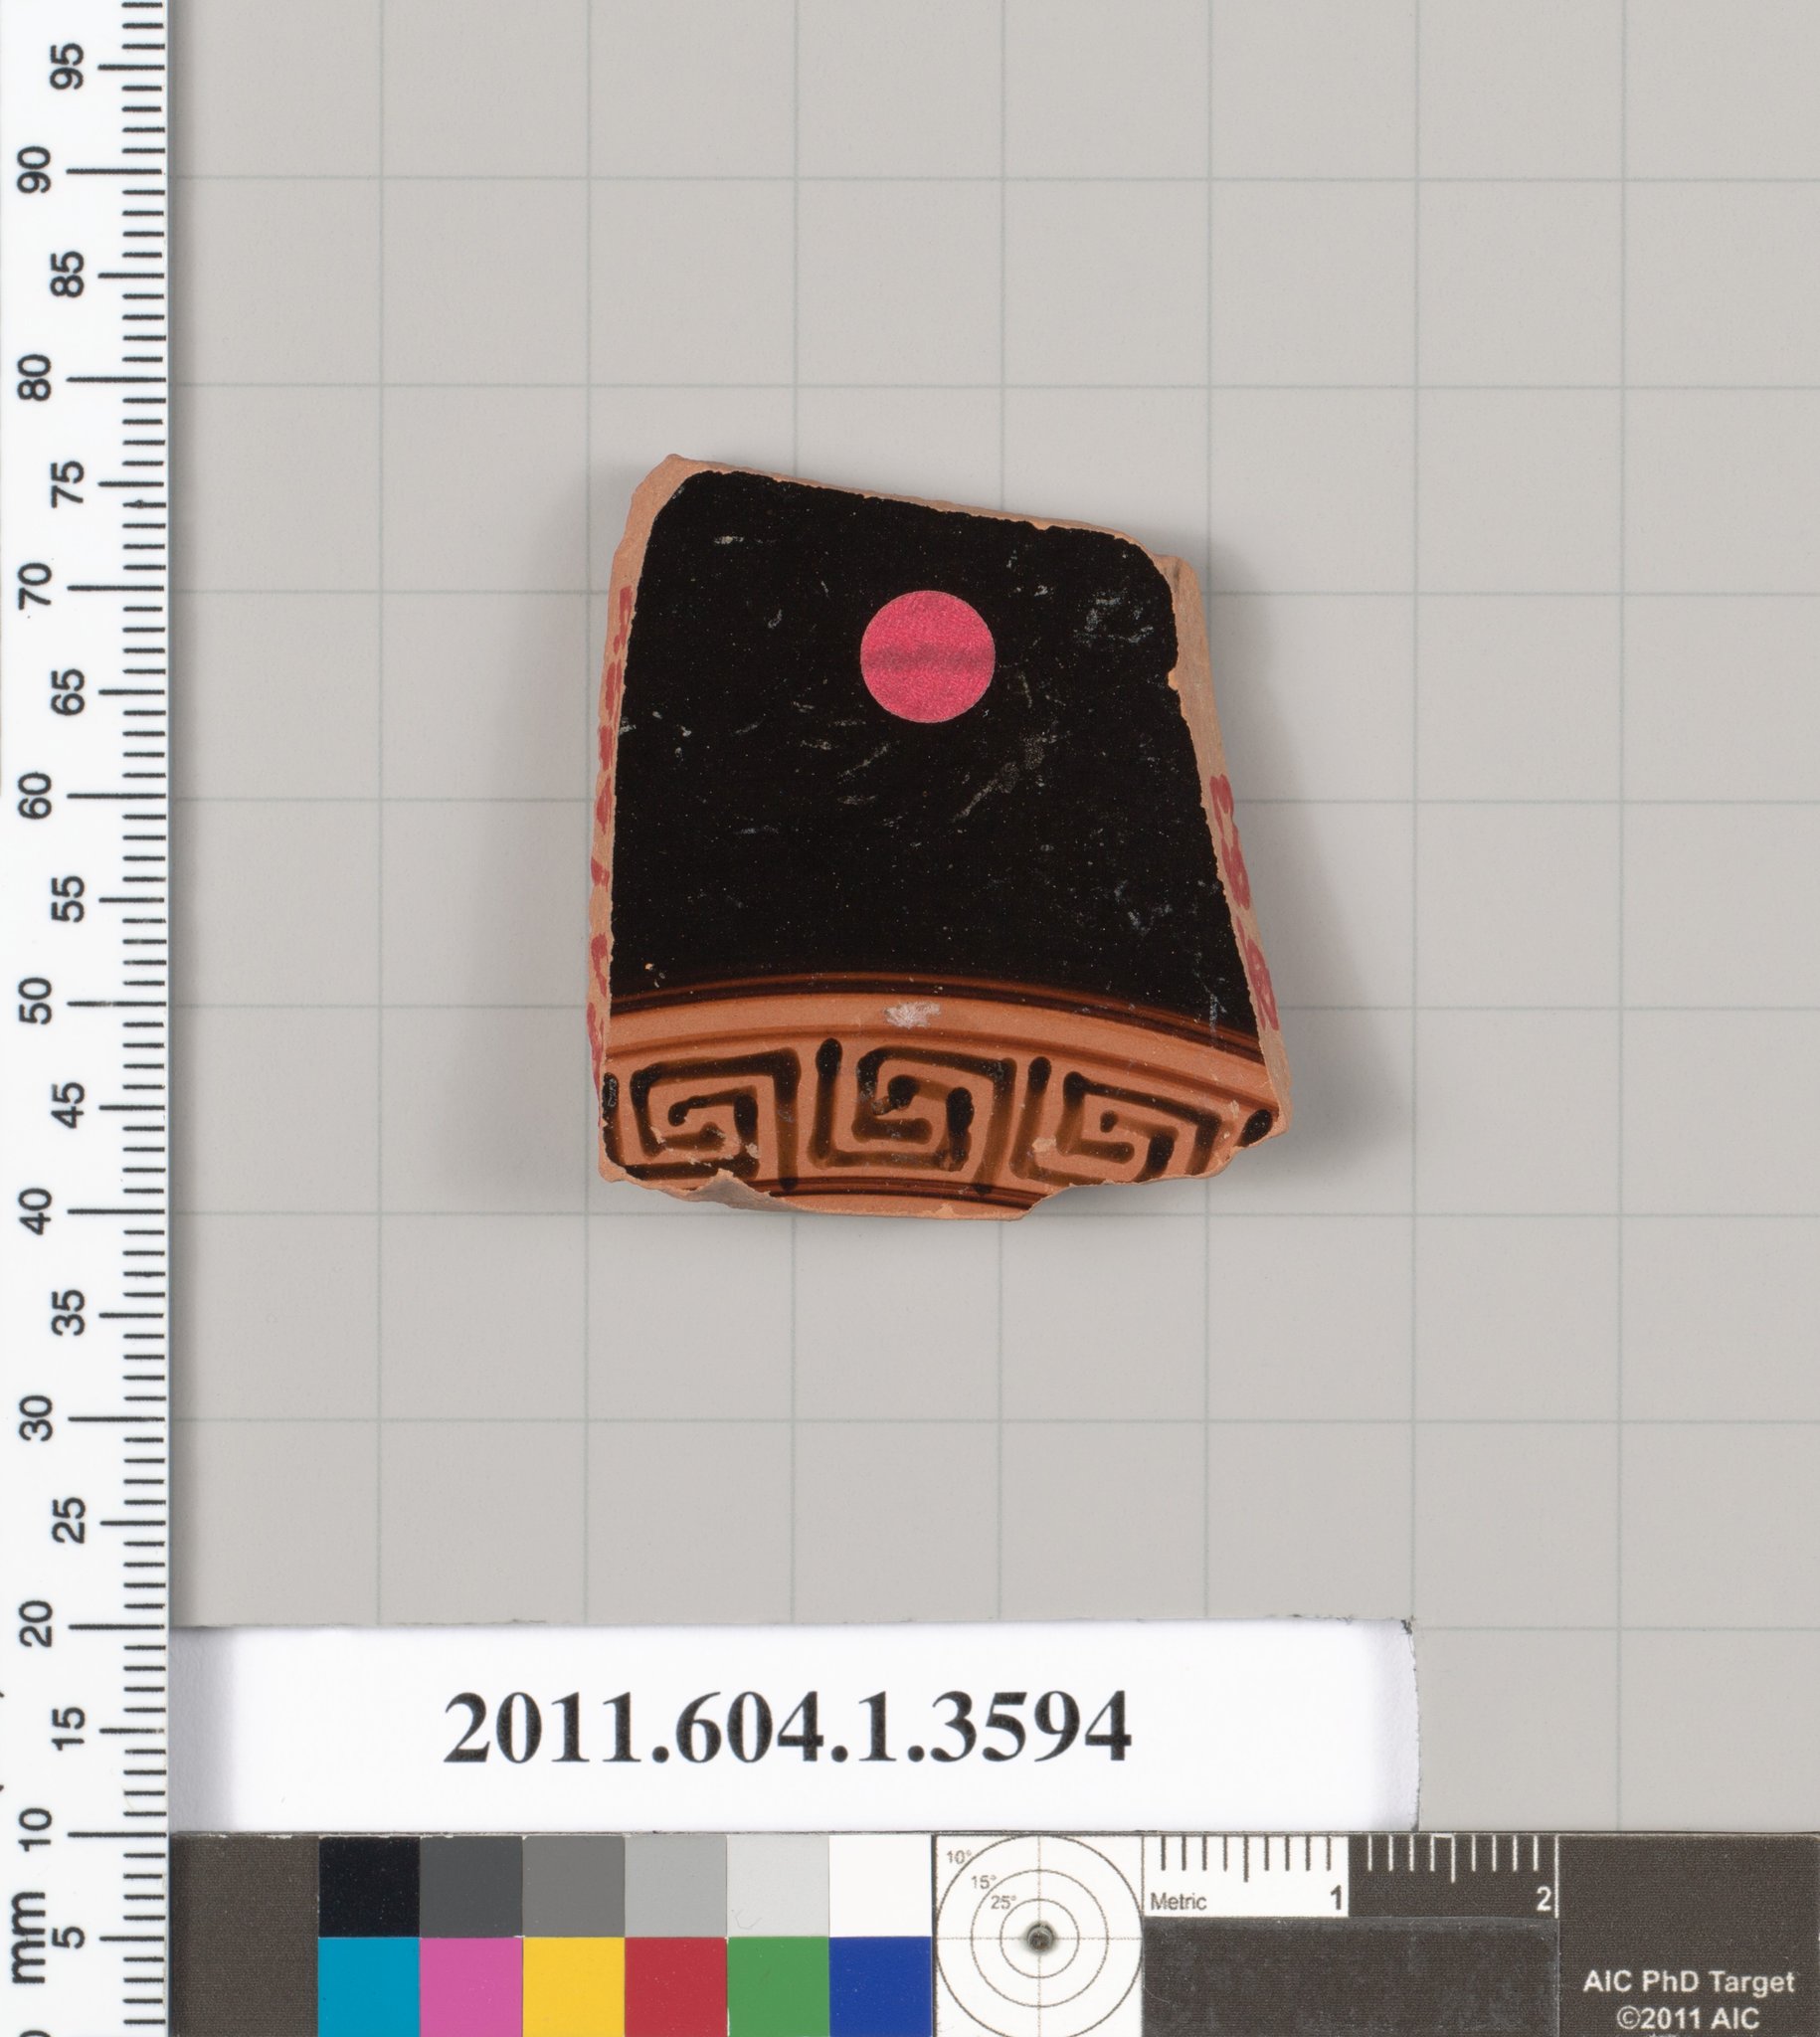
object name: kylix fragment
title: Terracotta fragment of a kylix (drinking cup)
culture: greek, attic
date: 490-470 BCE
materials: terracotta